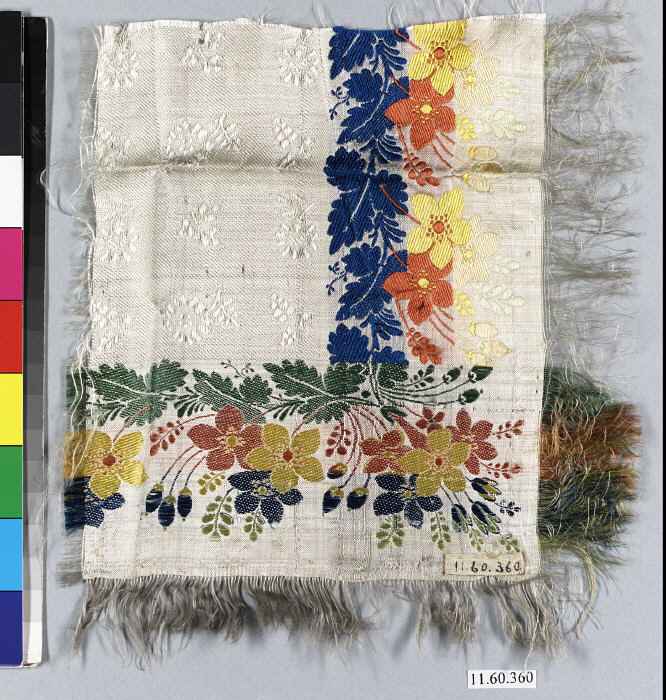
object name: fragment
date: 1801-1900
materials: silk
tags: flowers,leaves